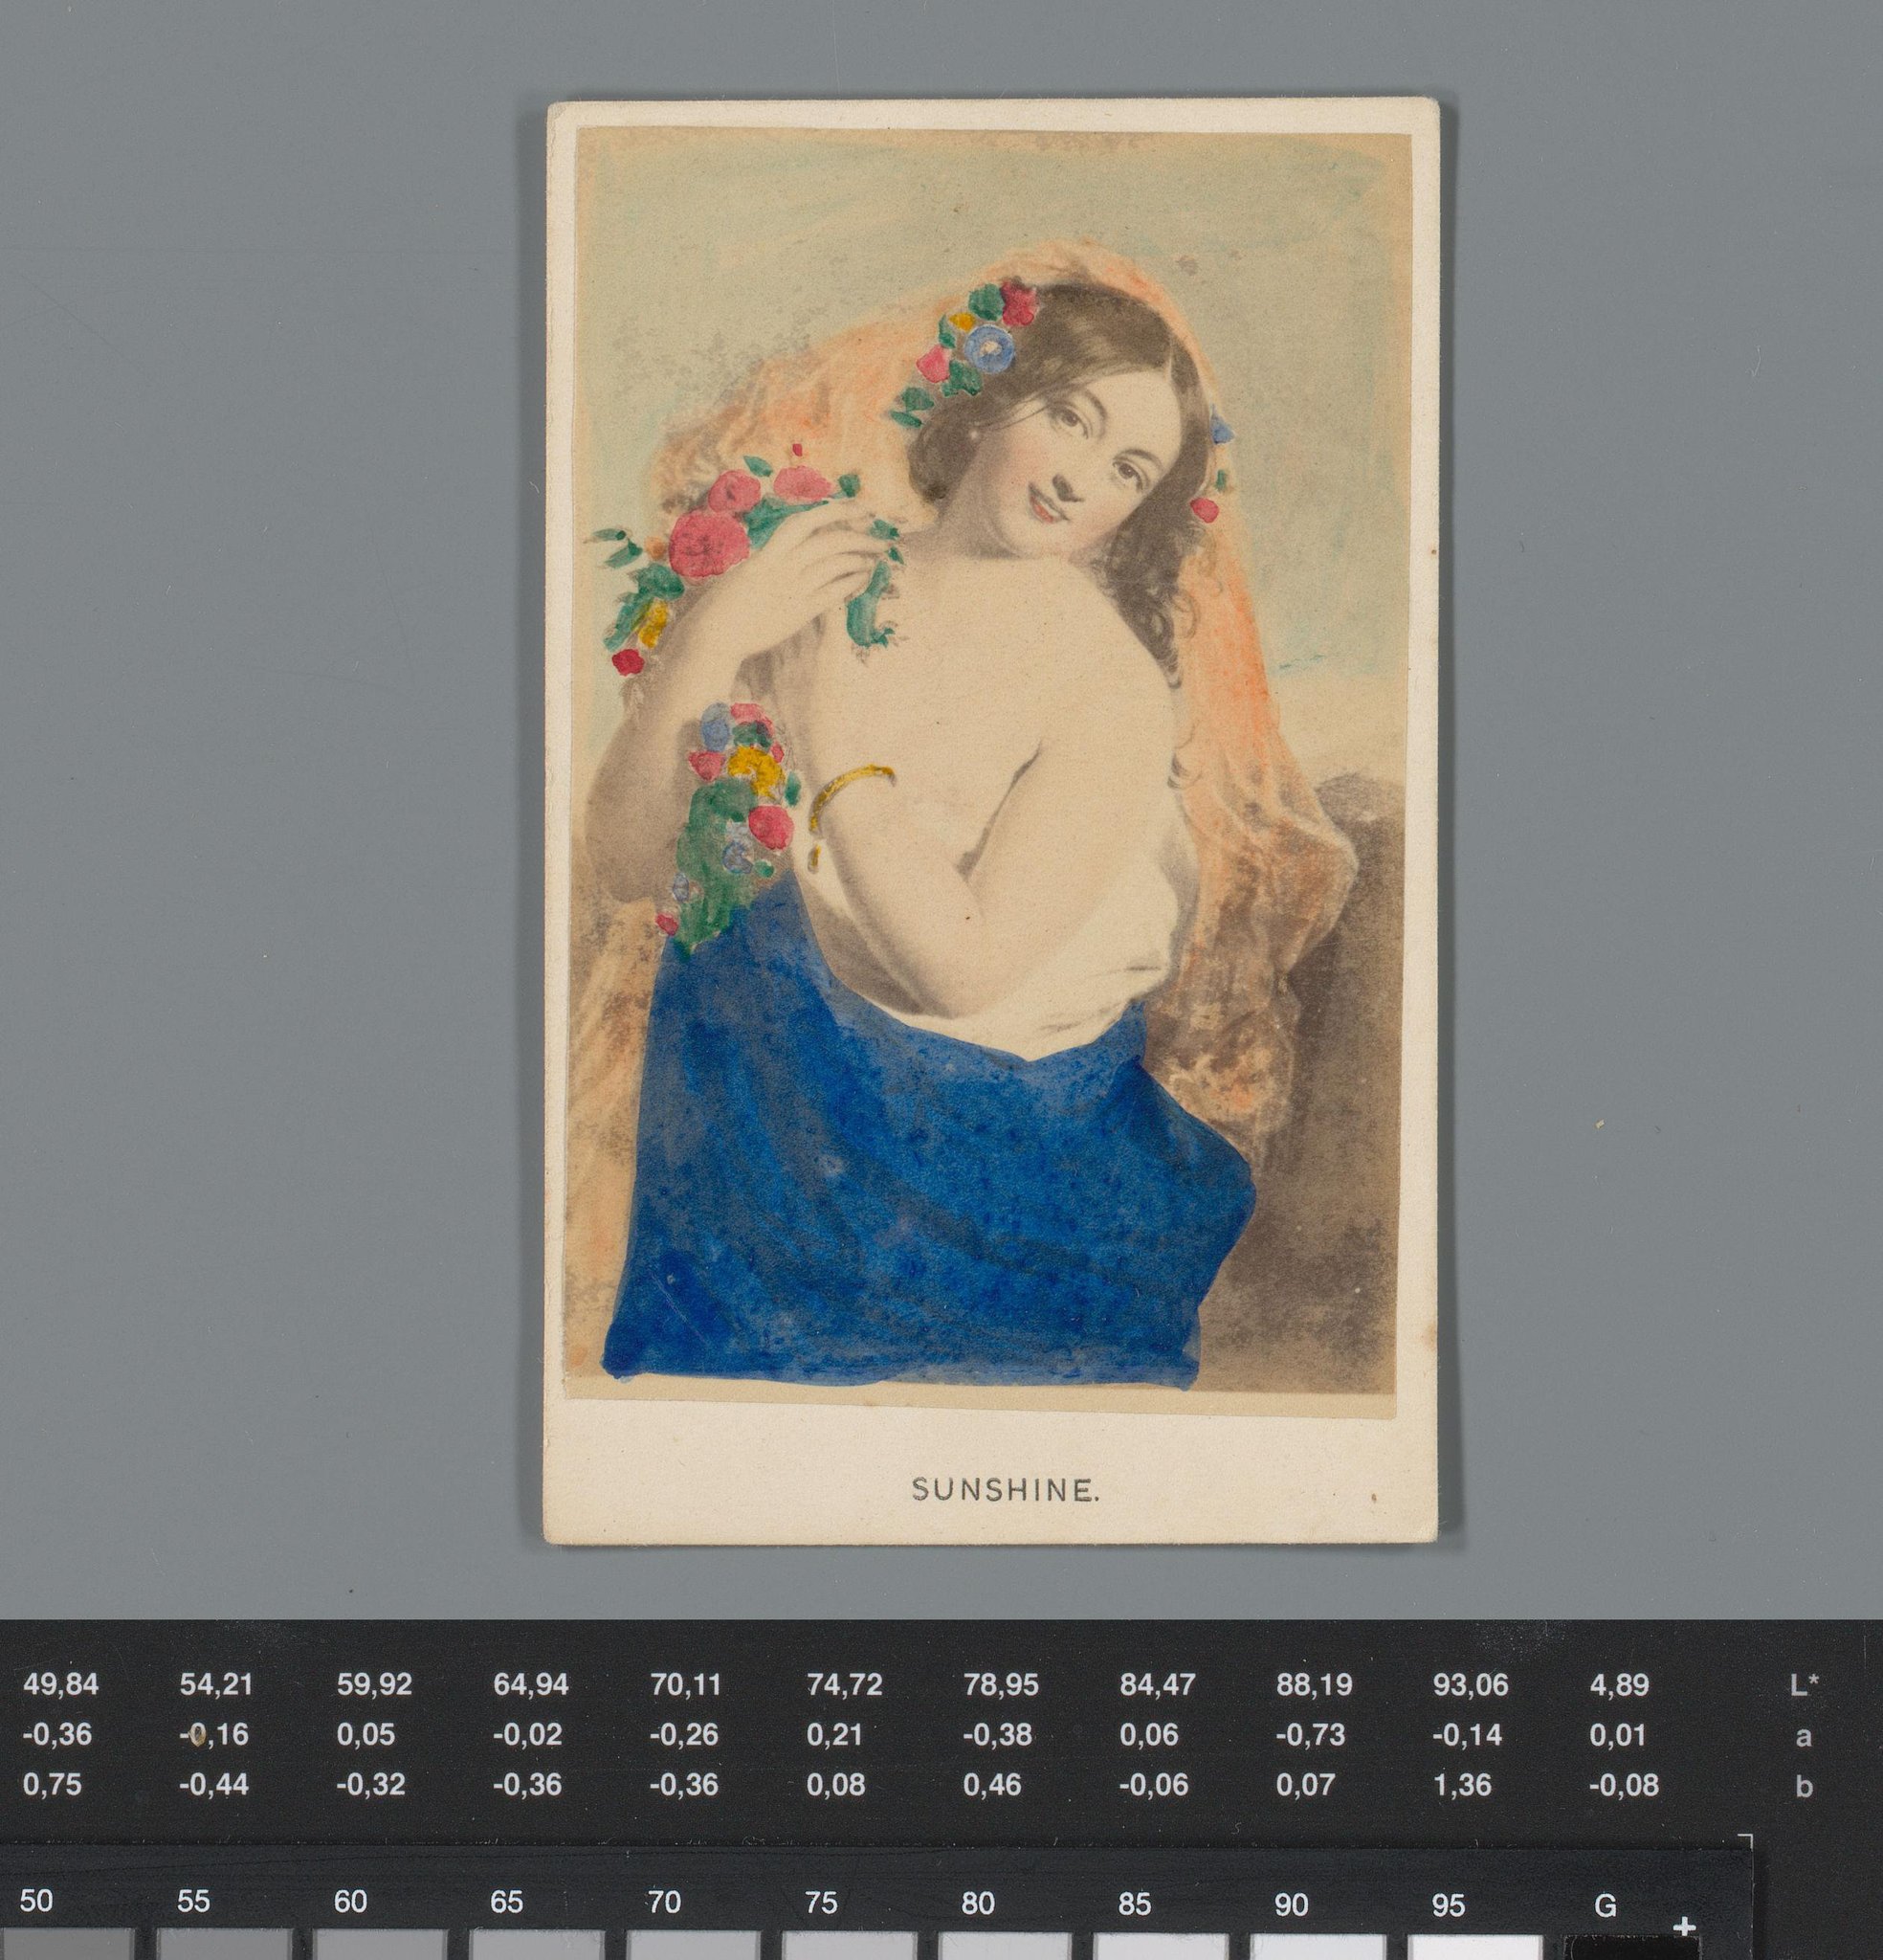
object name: carte de visite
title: Reclame voor fotoalbums van N. Hollister te Utica met portret van een onbekende vrouw met bloemensluier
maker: Anonymous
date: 1850-1915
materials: cardboard, paint, photographic support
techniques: albumen print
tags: advertising, historical persons not known by name - bb - woman, veil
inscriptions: inscription: ‘N HOLLISTER, / Wholesale and Retail Dealer in / Photograph Albums (...) Utica, N. Y.’